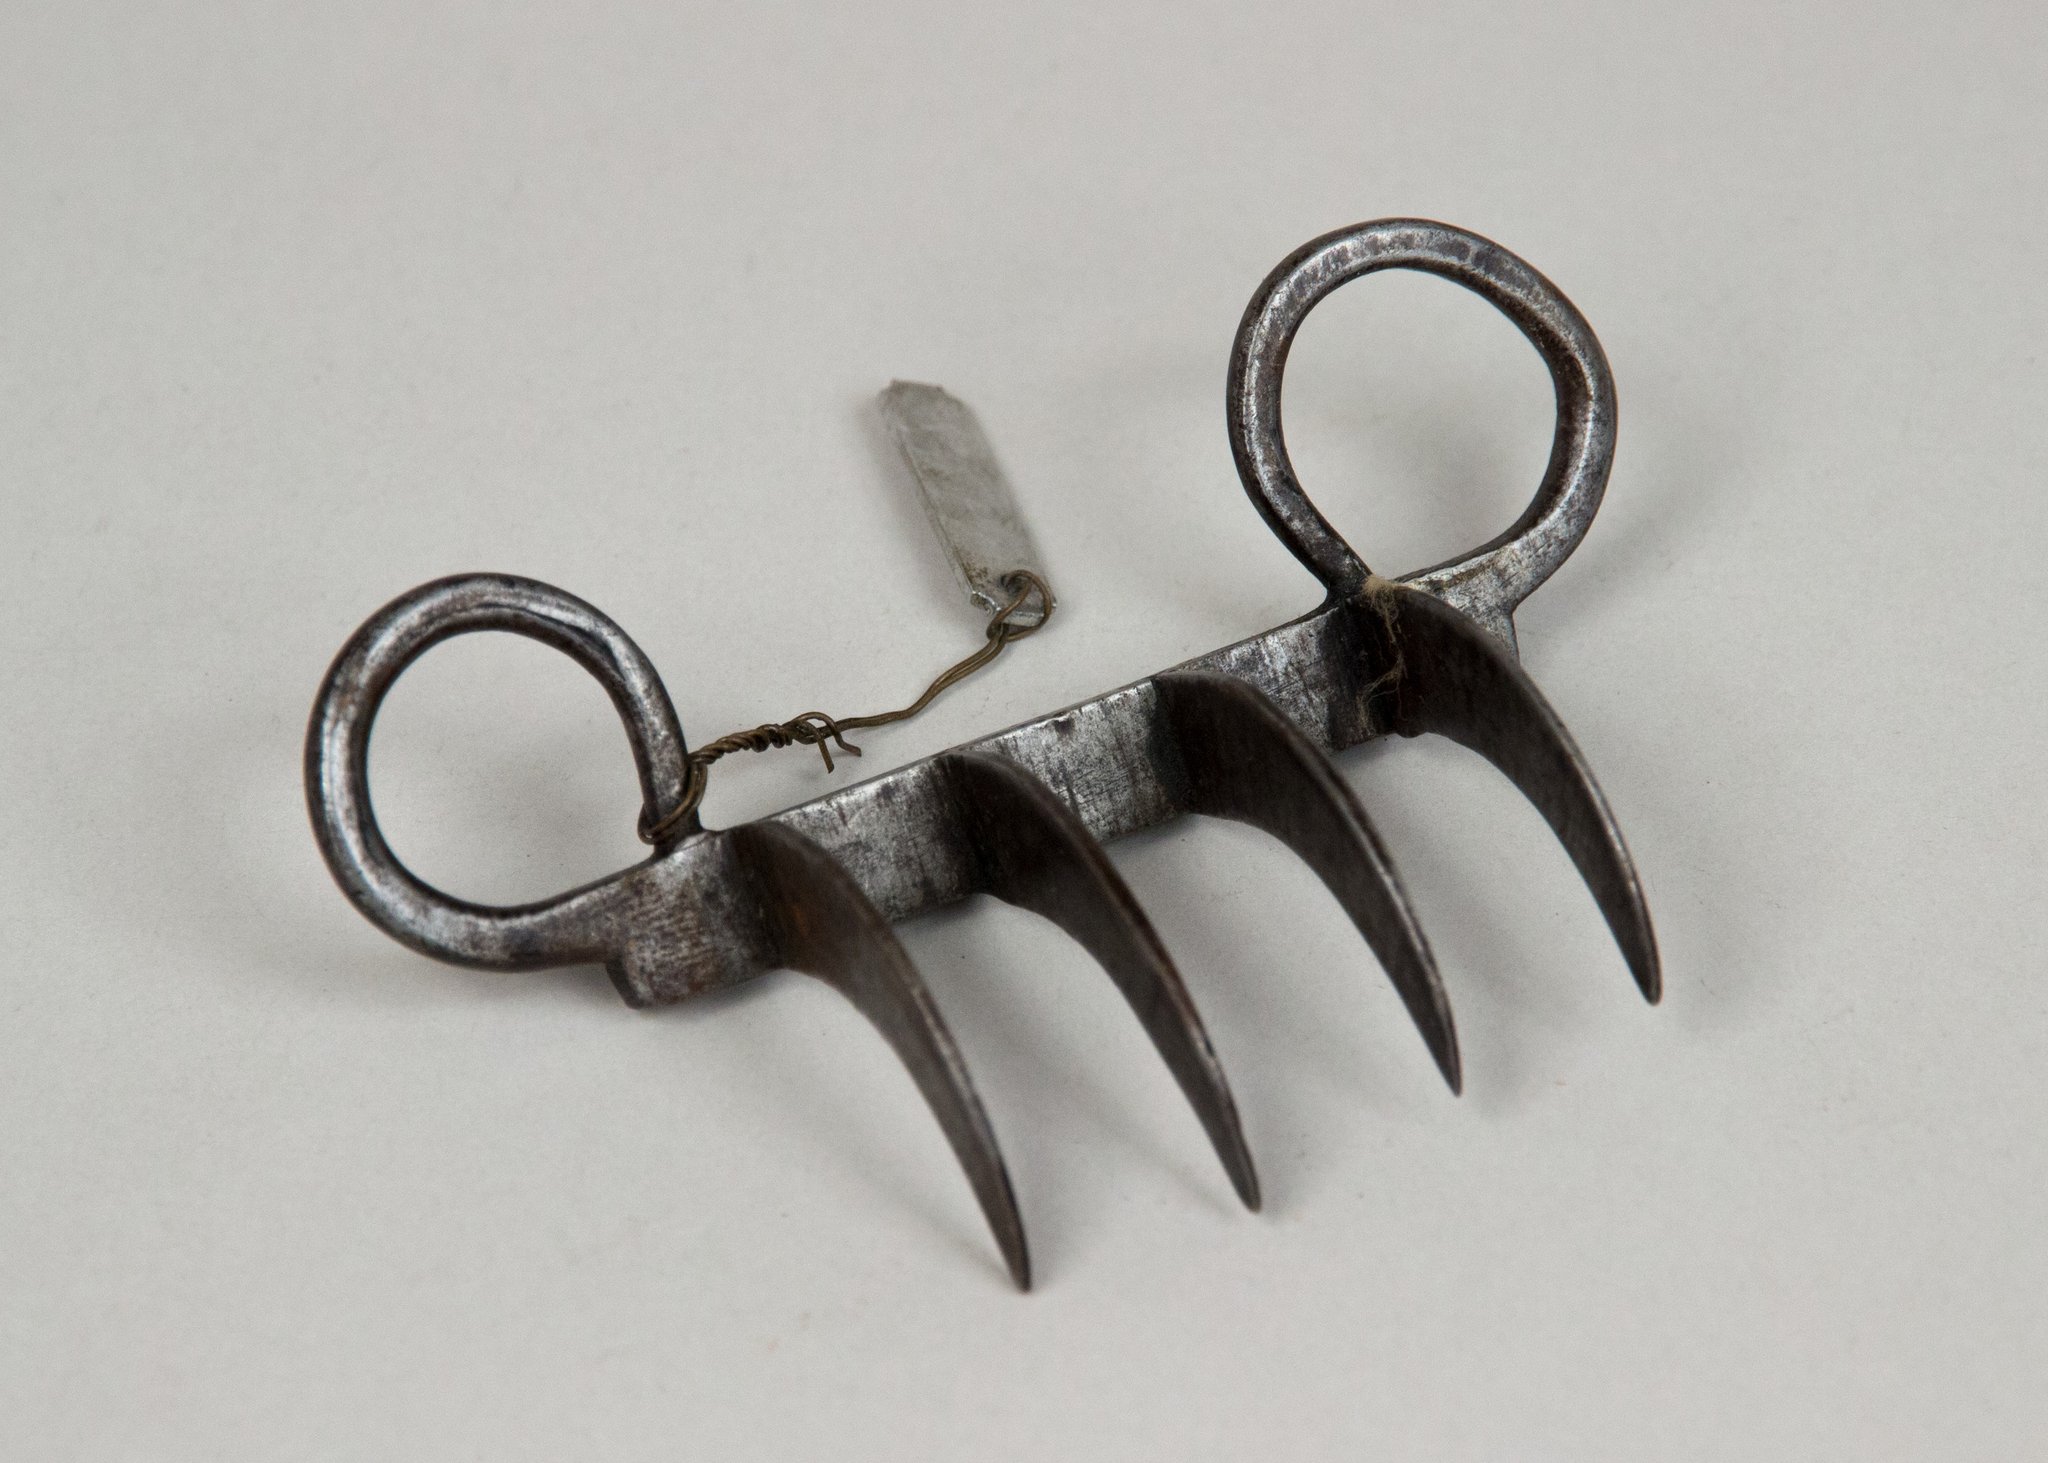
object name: tiger's claw bagh nakh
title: Tiger's Claw (Bagh Nakh)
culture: indian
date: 1701-1900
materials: steel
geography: india